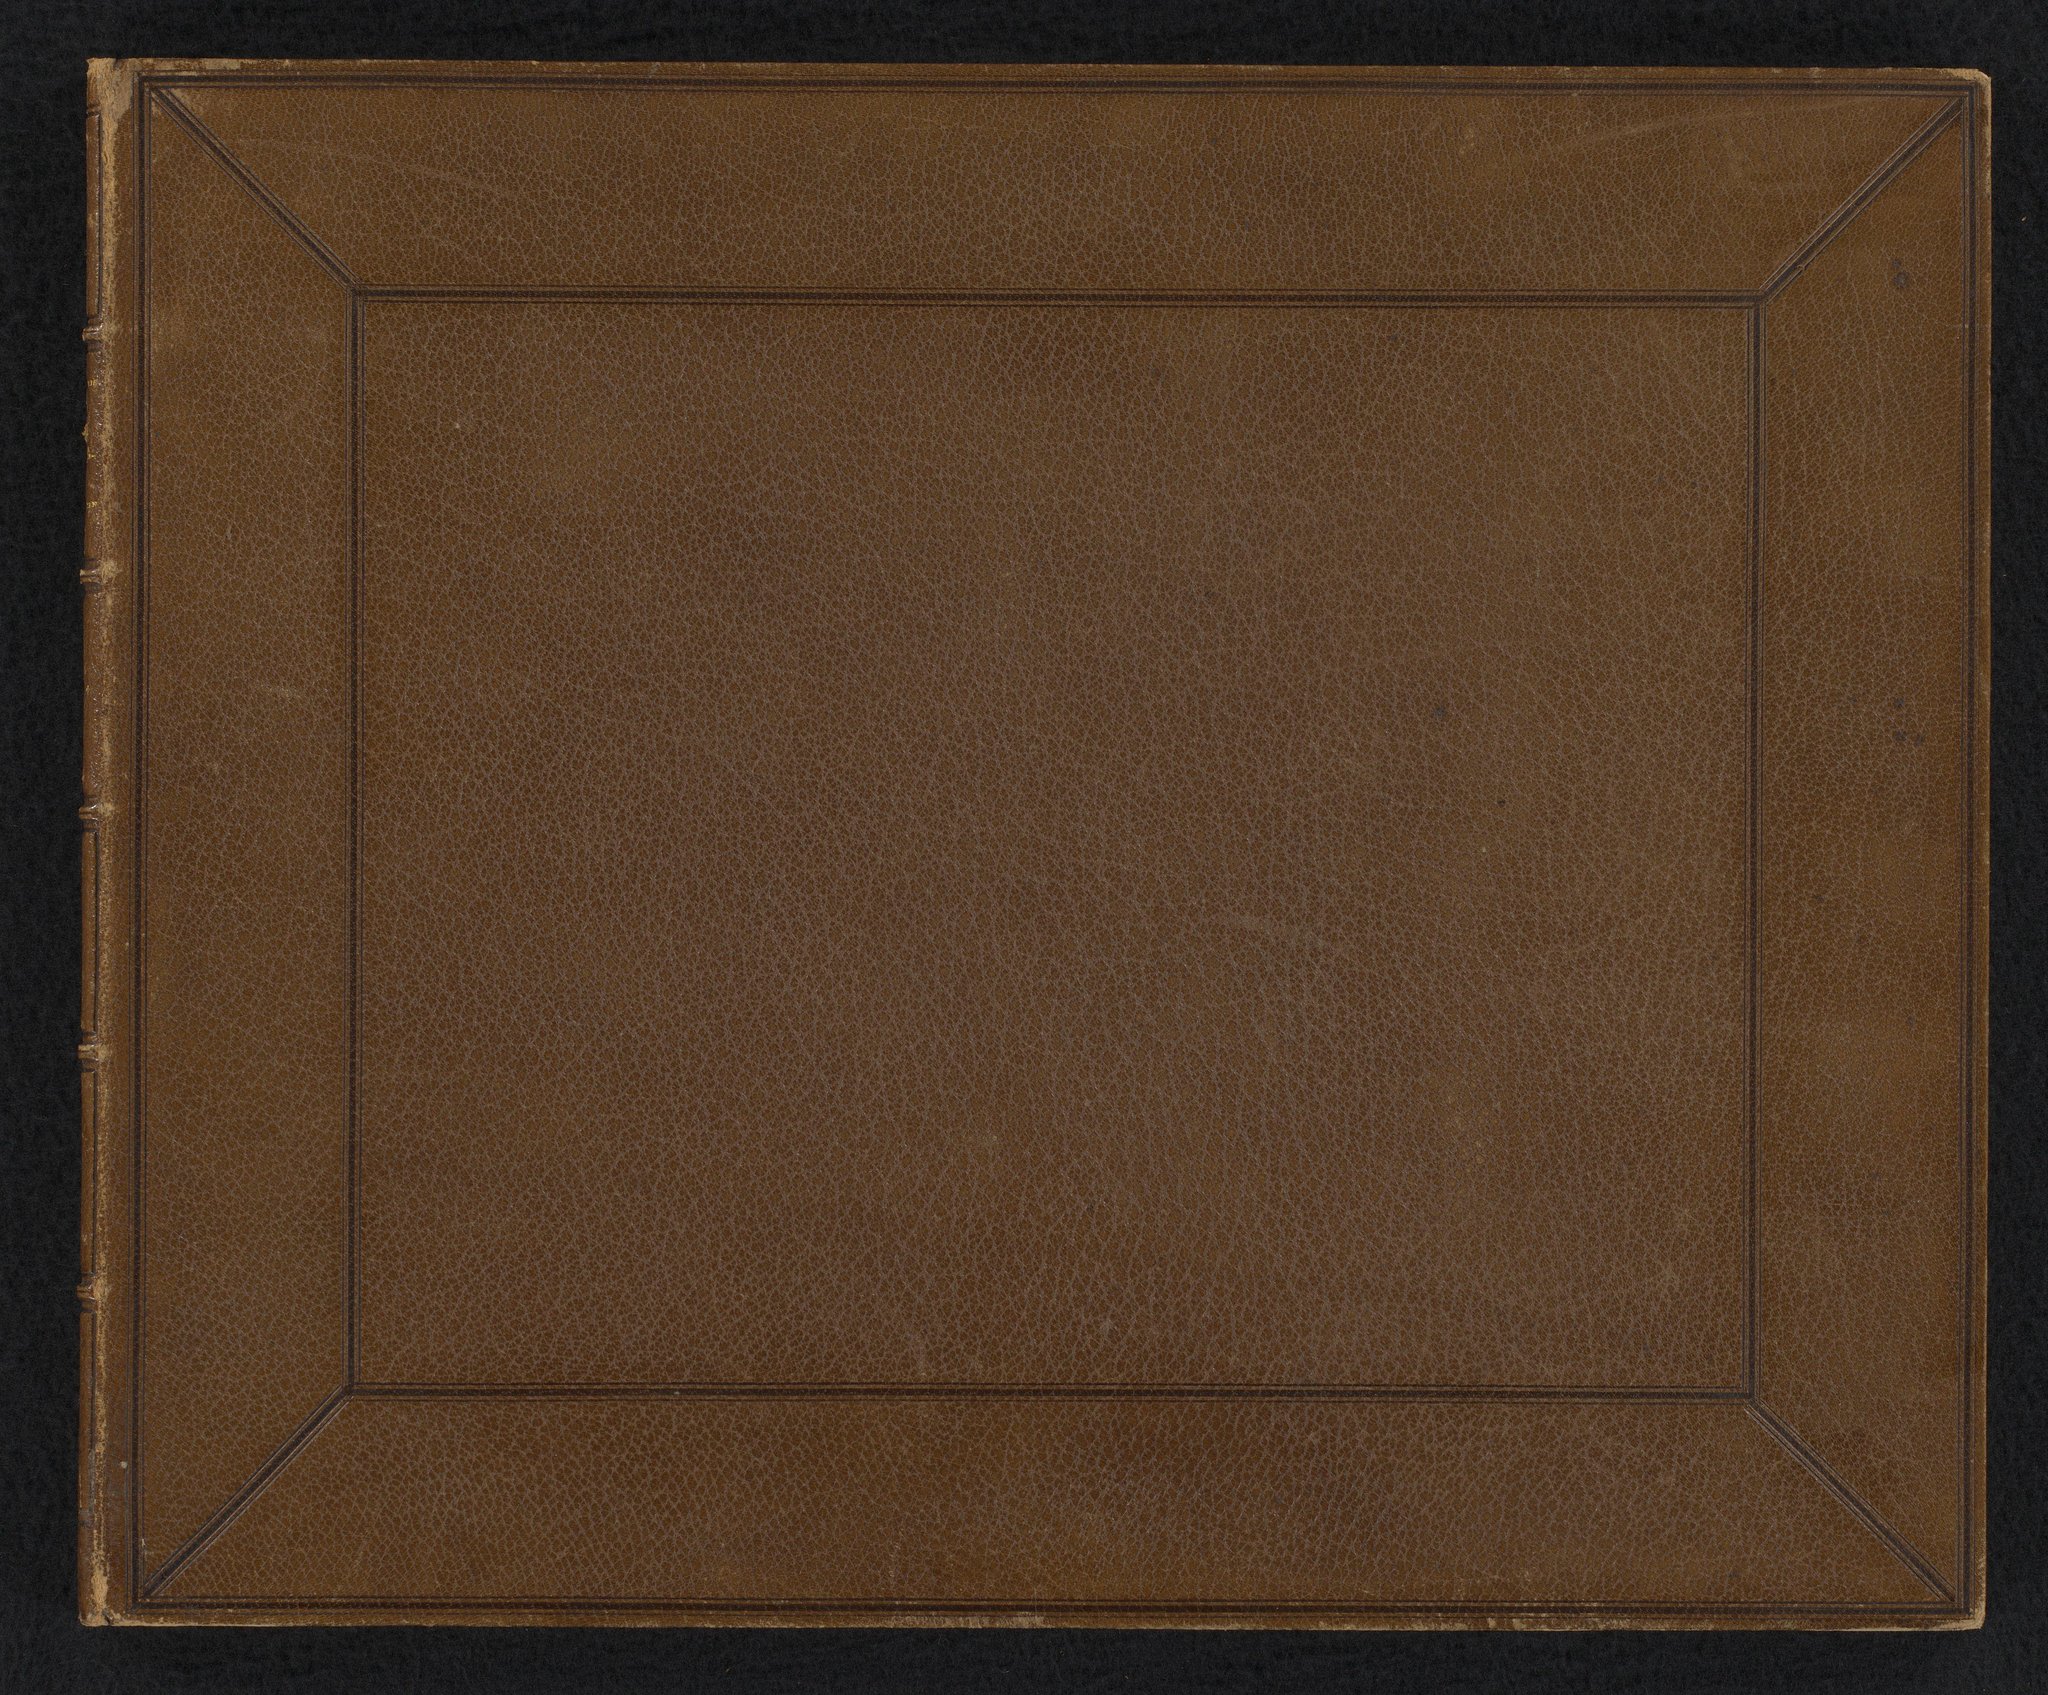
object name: prentrecueil, prentenalbum, prentalbum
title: J. Floris - Compertementen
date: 1564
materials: leather, paper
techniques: bookbinding, decorated paper, engraving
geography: amsterdam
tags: ornaments ~ art, ornament ~ cartouche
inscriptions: inscription: ‘27// II 8’, collector's mark: Lugt 2166, inscription: ‘is.zn’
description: Album met twaalf gravures op twaalf albumbladen. Het betreft de serie getiteld: Veelderhande cierlijcke compertementen profitelijck voor schilders goutsmeden beeldtsnijders ende ander constenaren. Het gaat om een titelprent en elf (van de twaalf) gedecoreerde cartouches. Bruin marokijnen band, met voorin en achterin een schutblad.